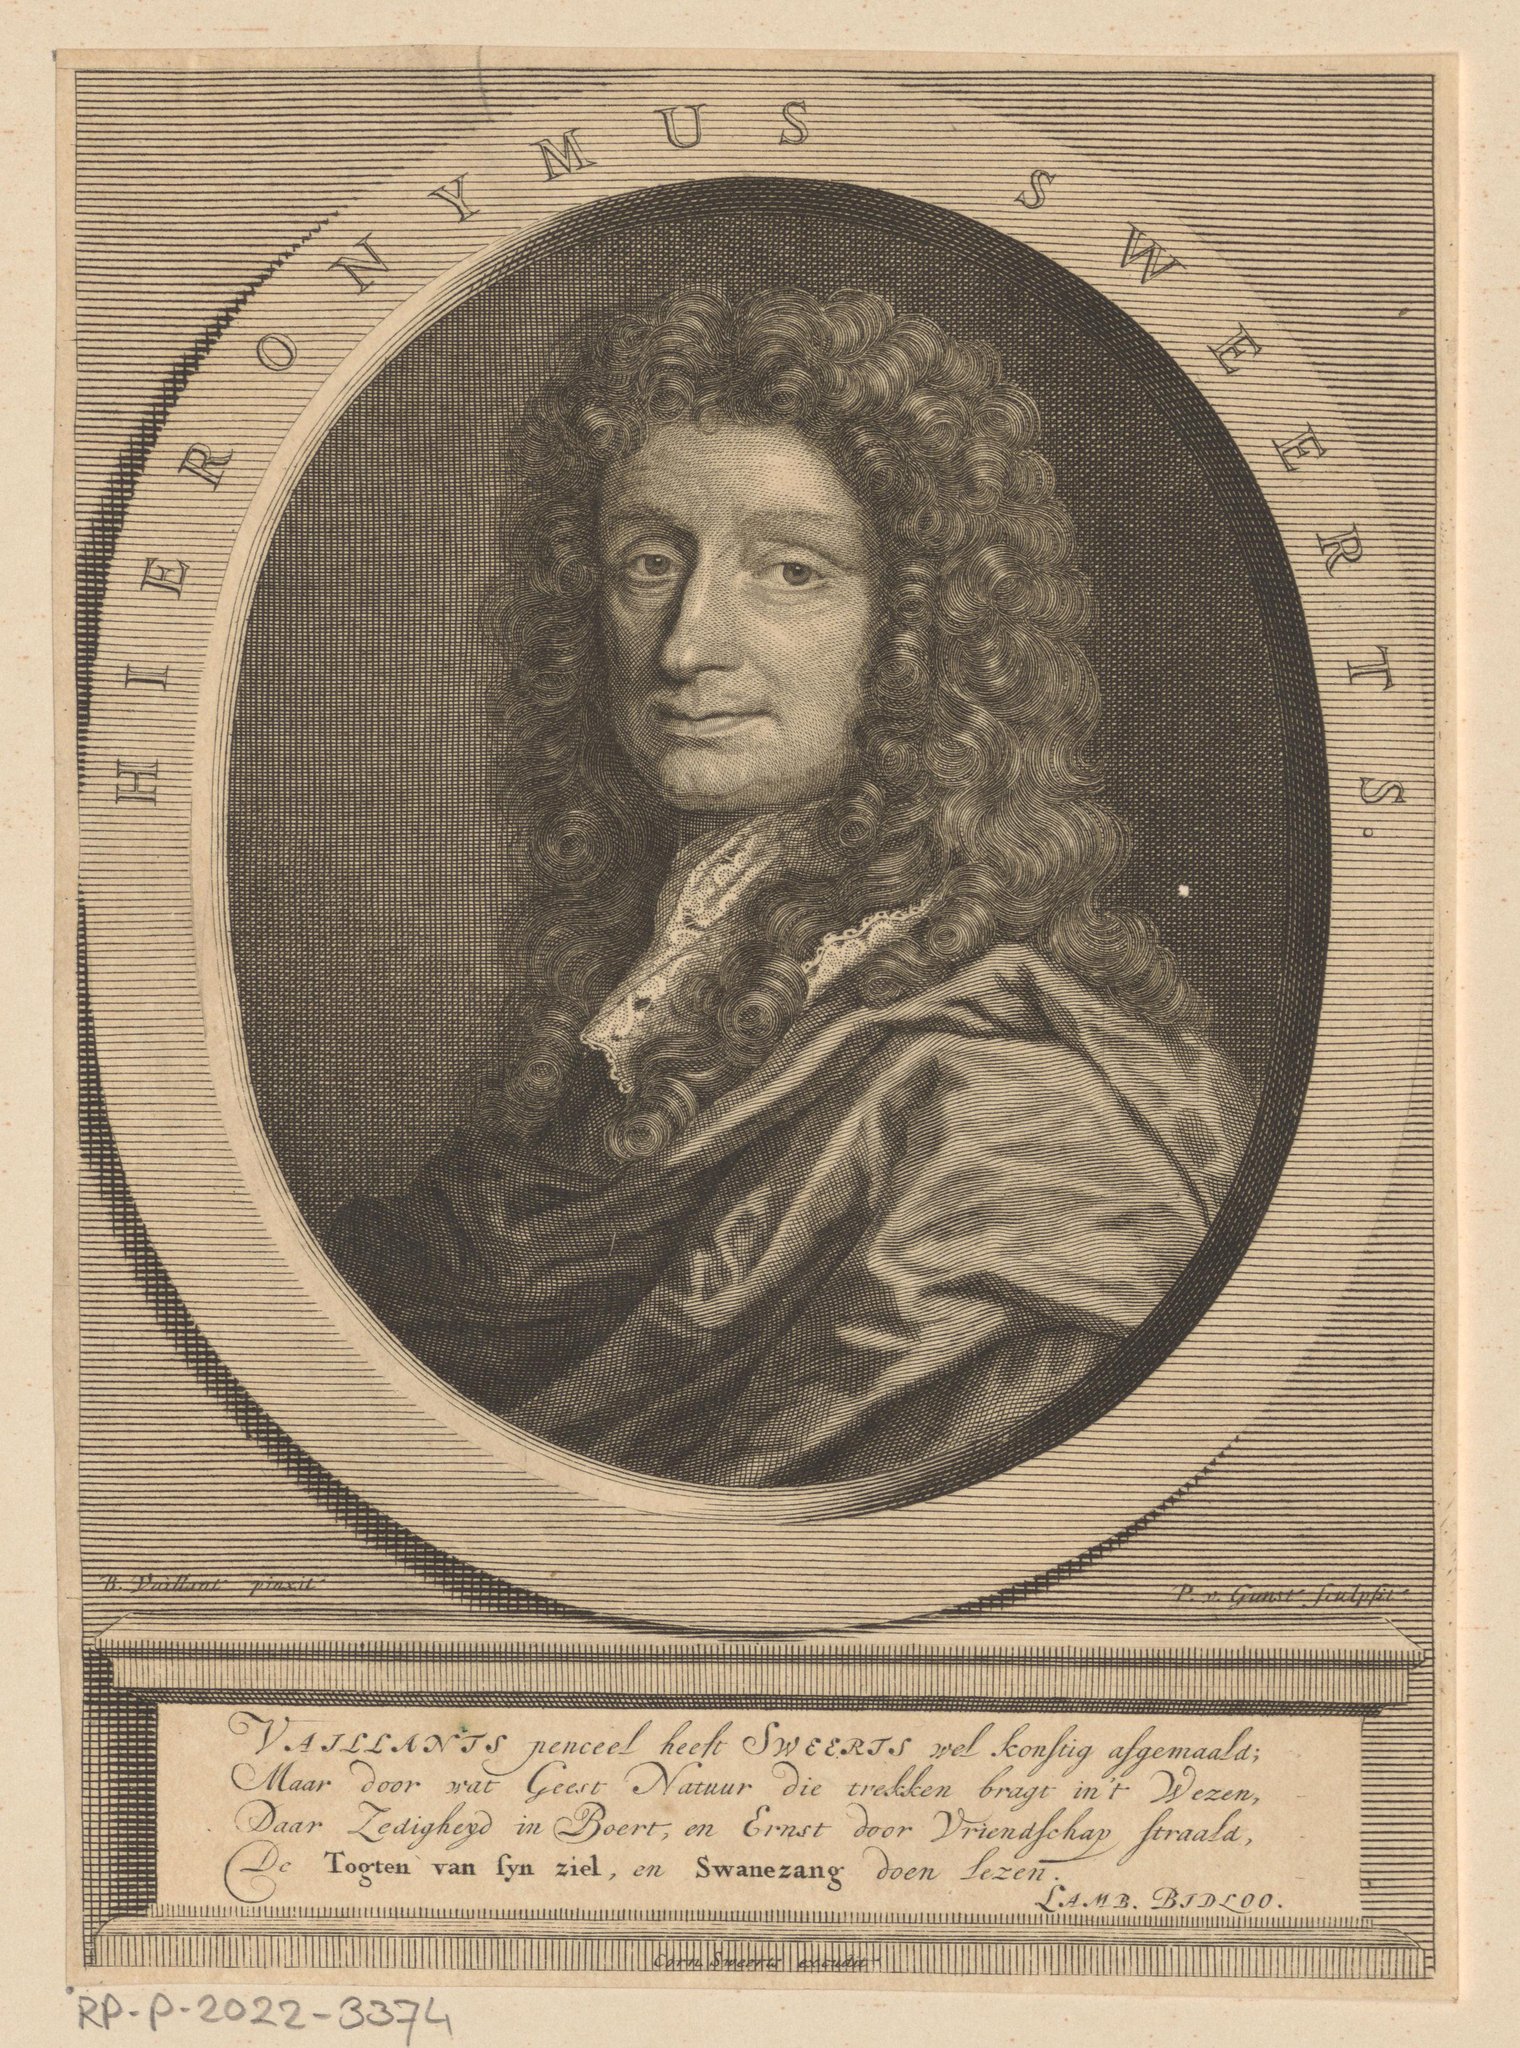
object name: print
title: Portret van Hieronymus Sweerts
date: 1694-1700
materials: paper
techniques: engraving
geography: amsterdam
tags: publisher, hieronymus sweerts, historical persons, writer, poet, author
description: Met een vierregelig vers in het Nederlands onder het portret.